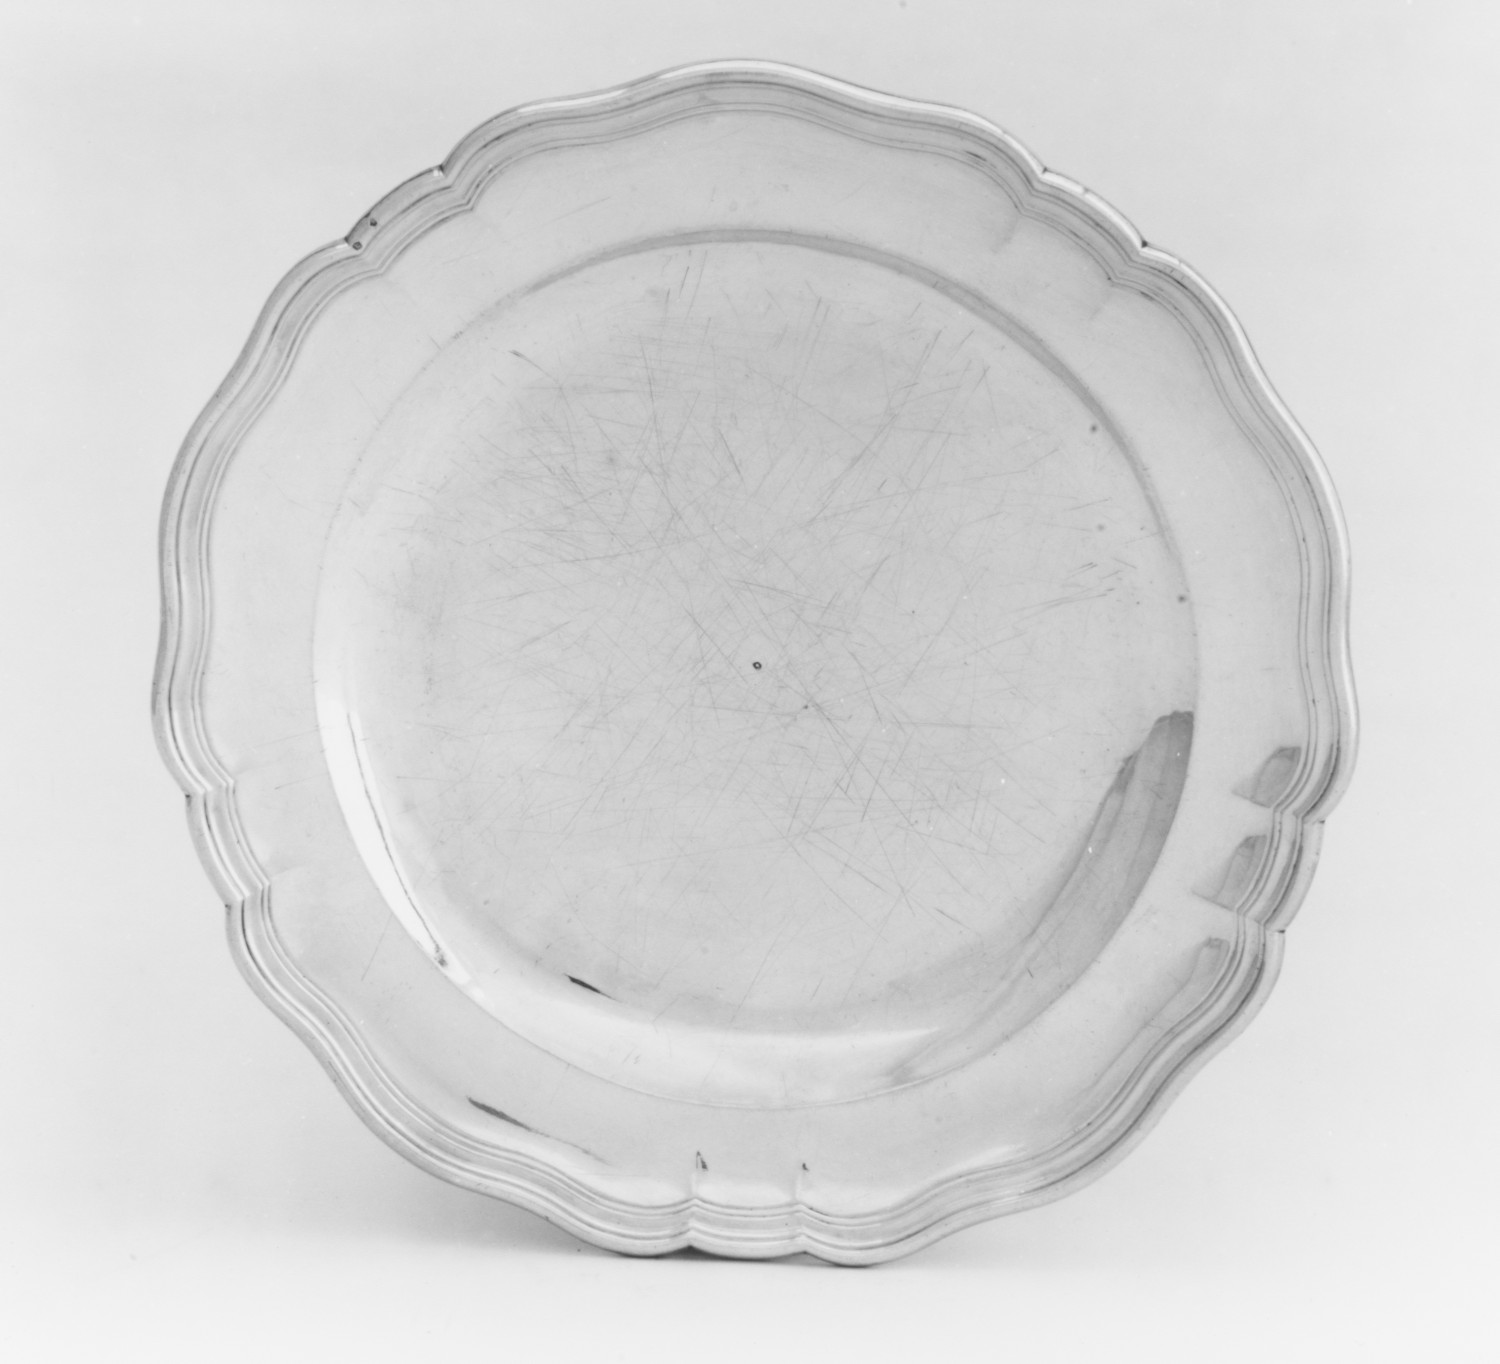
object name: plate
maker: edme-pierre balzac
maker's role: maker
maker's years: 1705-1786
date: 1771-1772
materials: silver